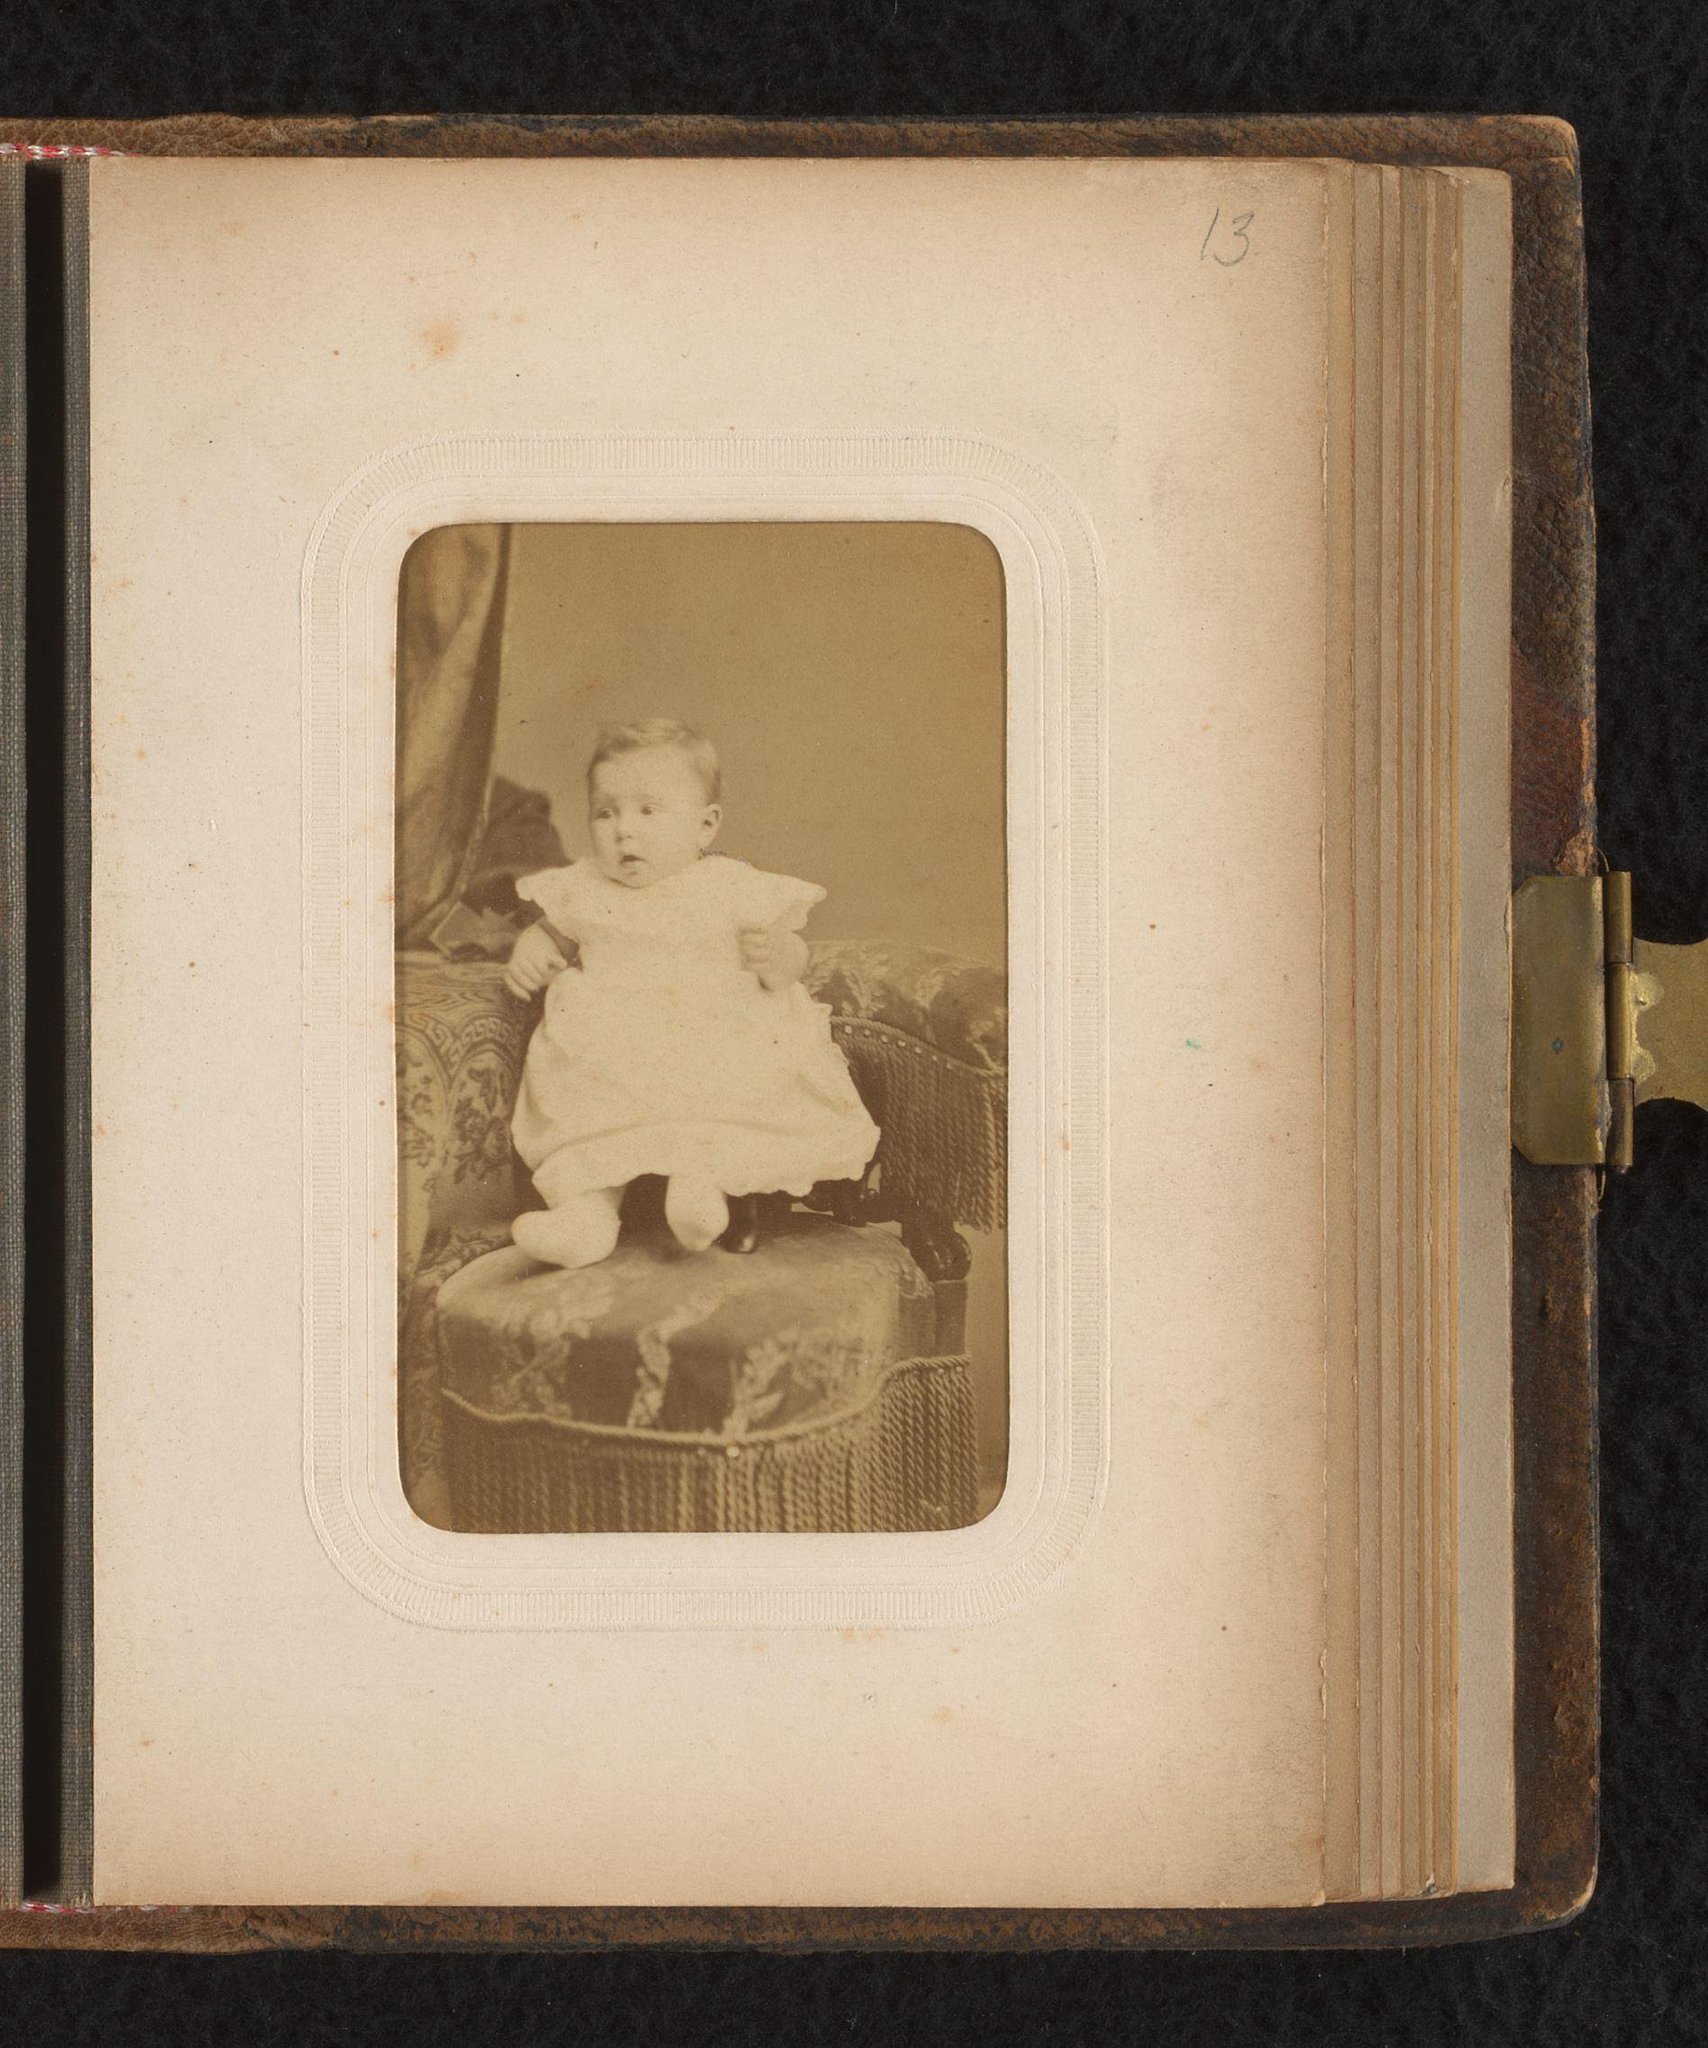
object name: carte de visite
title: Portret van Cornelia Maria Bon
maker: louis robert werner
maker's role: fotograaf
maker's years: 1834-1896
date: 1879-1882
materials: cardboard, paper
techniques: albumen print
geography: amsterdam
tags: historical persons - bb - woman, infant, baby ~ the ages of man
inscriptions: inscription: ‘L.R. Werner Amsterdam’, inscription: ‘Cornelia Maria/ Bon?’, inscription: ‘L.R. Werner/ voorheen/ P. Carstensen/ Nieuwendyk H.150. (...) geleverd worden.’